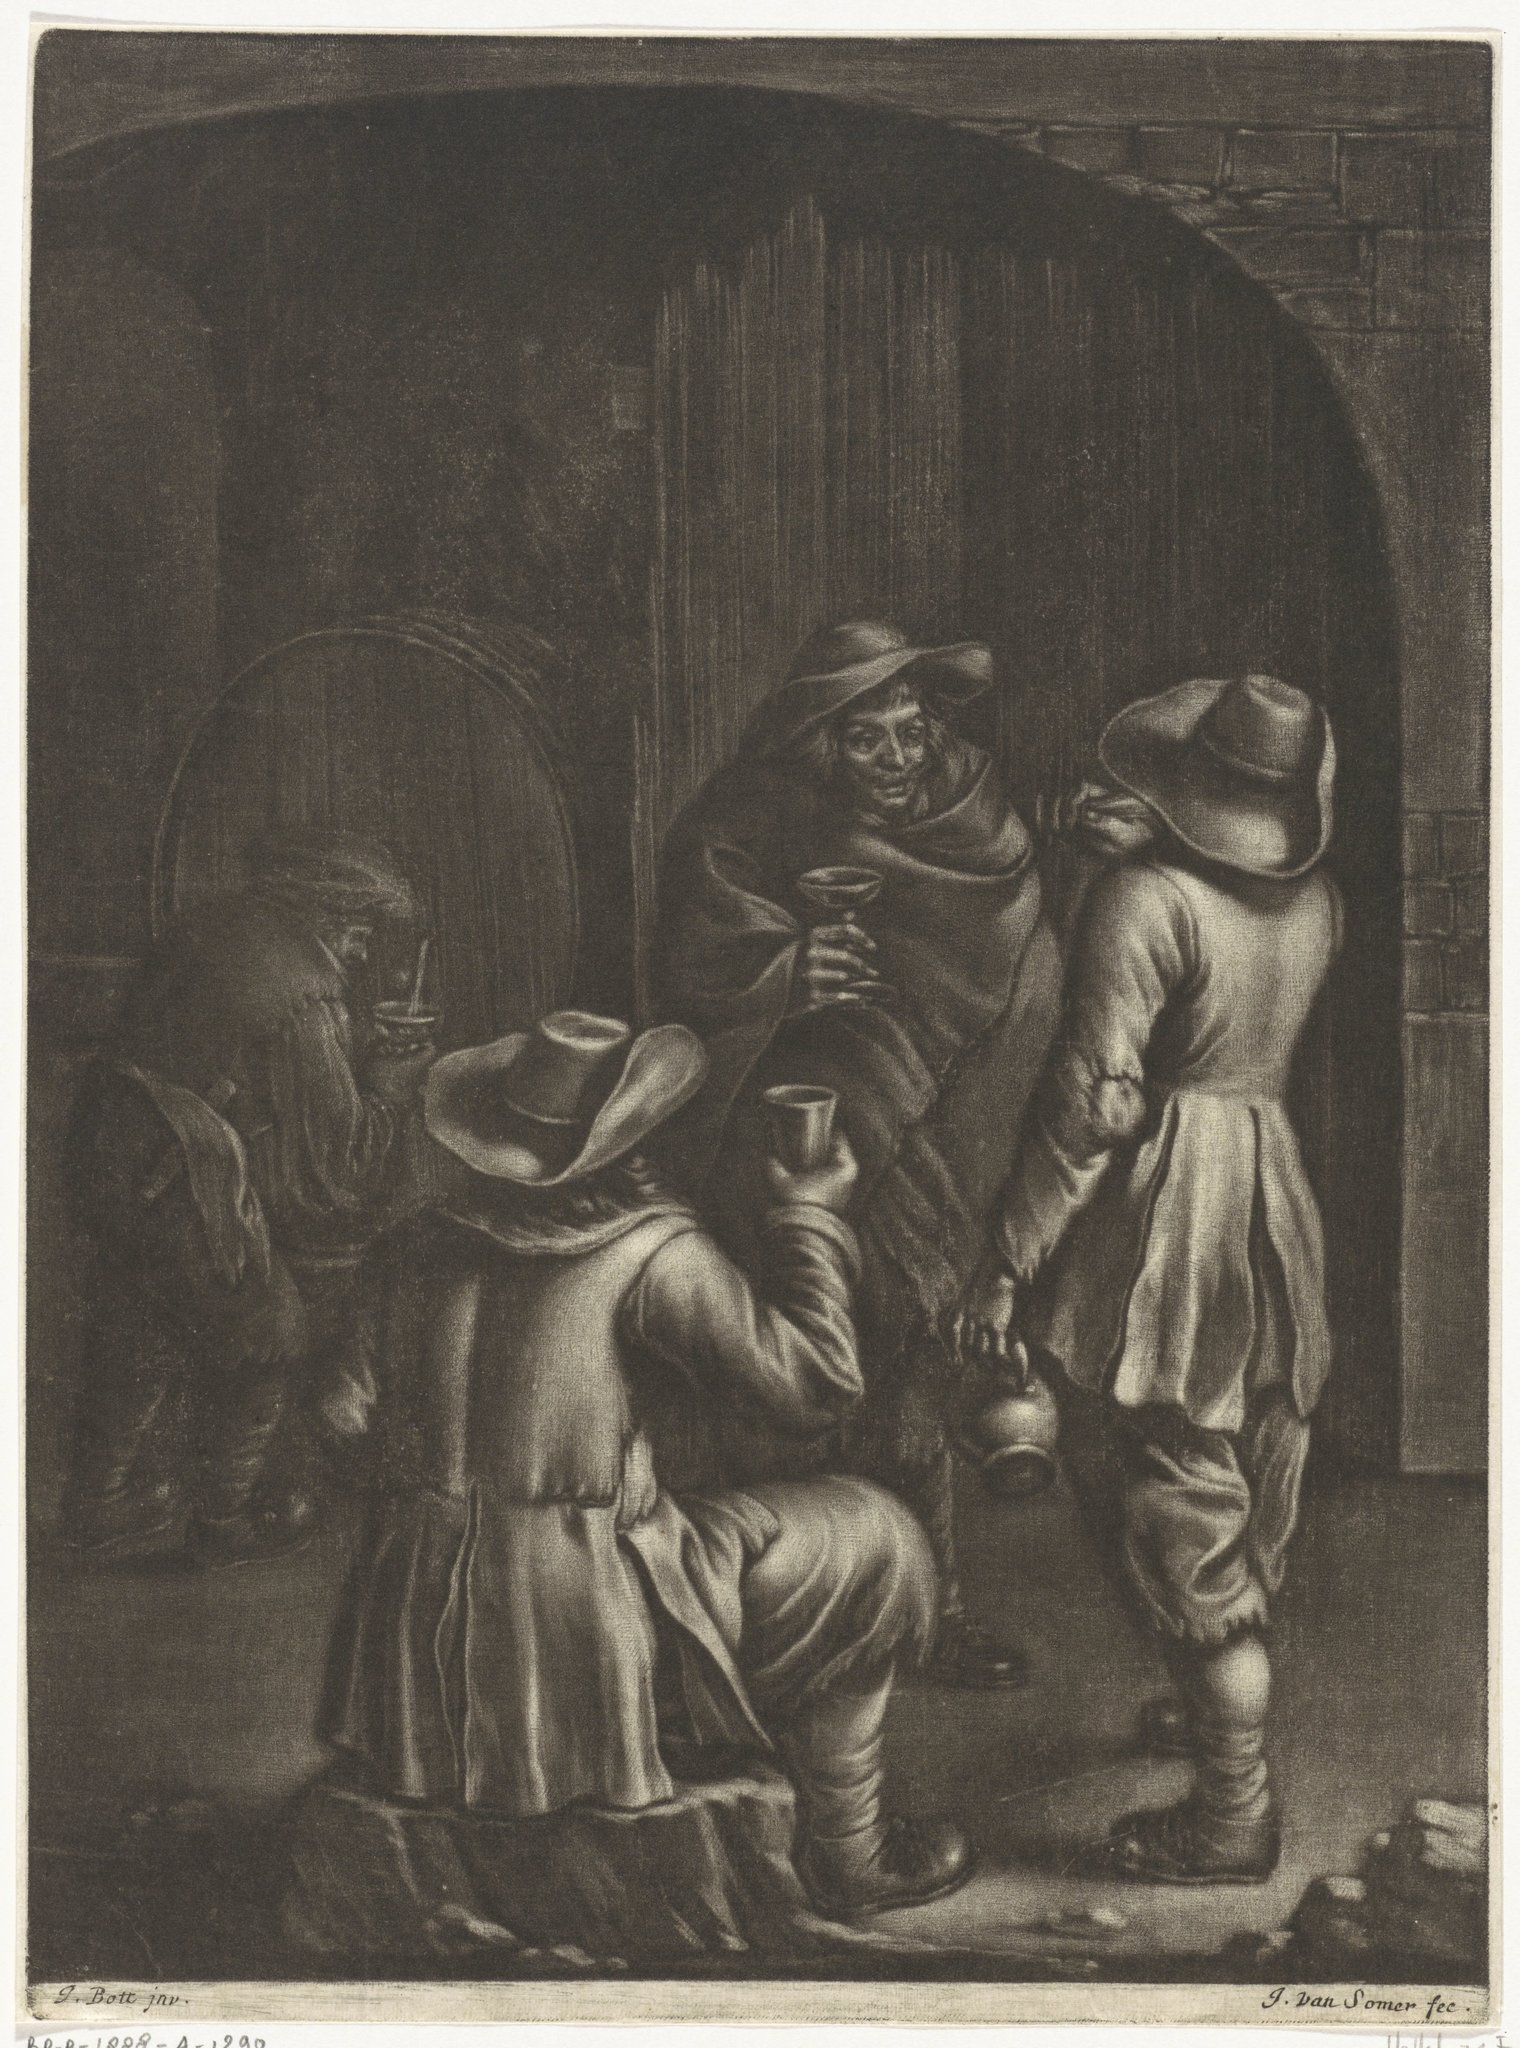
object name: print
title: Wijn proeven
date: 1655-1700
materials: paper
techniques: mezzotint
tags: wine-testing, wine-grading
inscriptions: collector's mark: Lugt 2228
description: Vier mannen proeven wijn. Een van hen neemt een slok, de ander vult zijn roemer en laatste twee heffen hun glas. Op de achtergrond een wijnton.